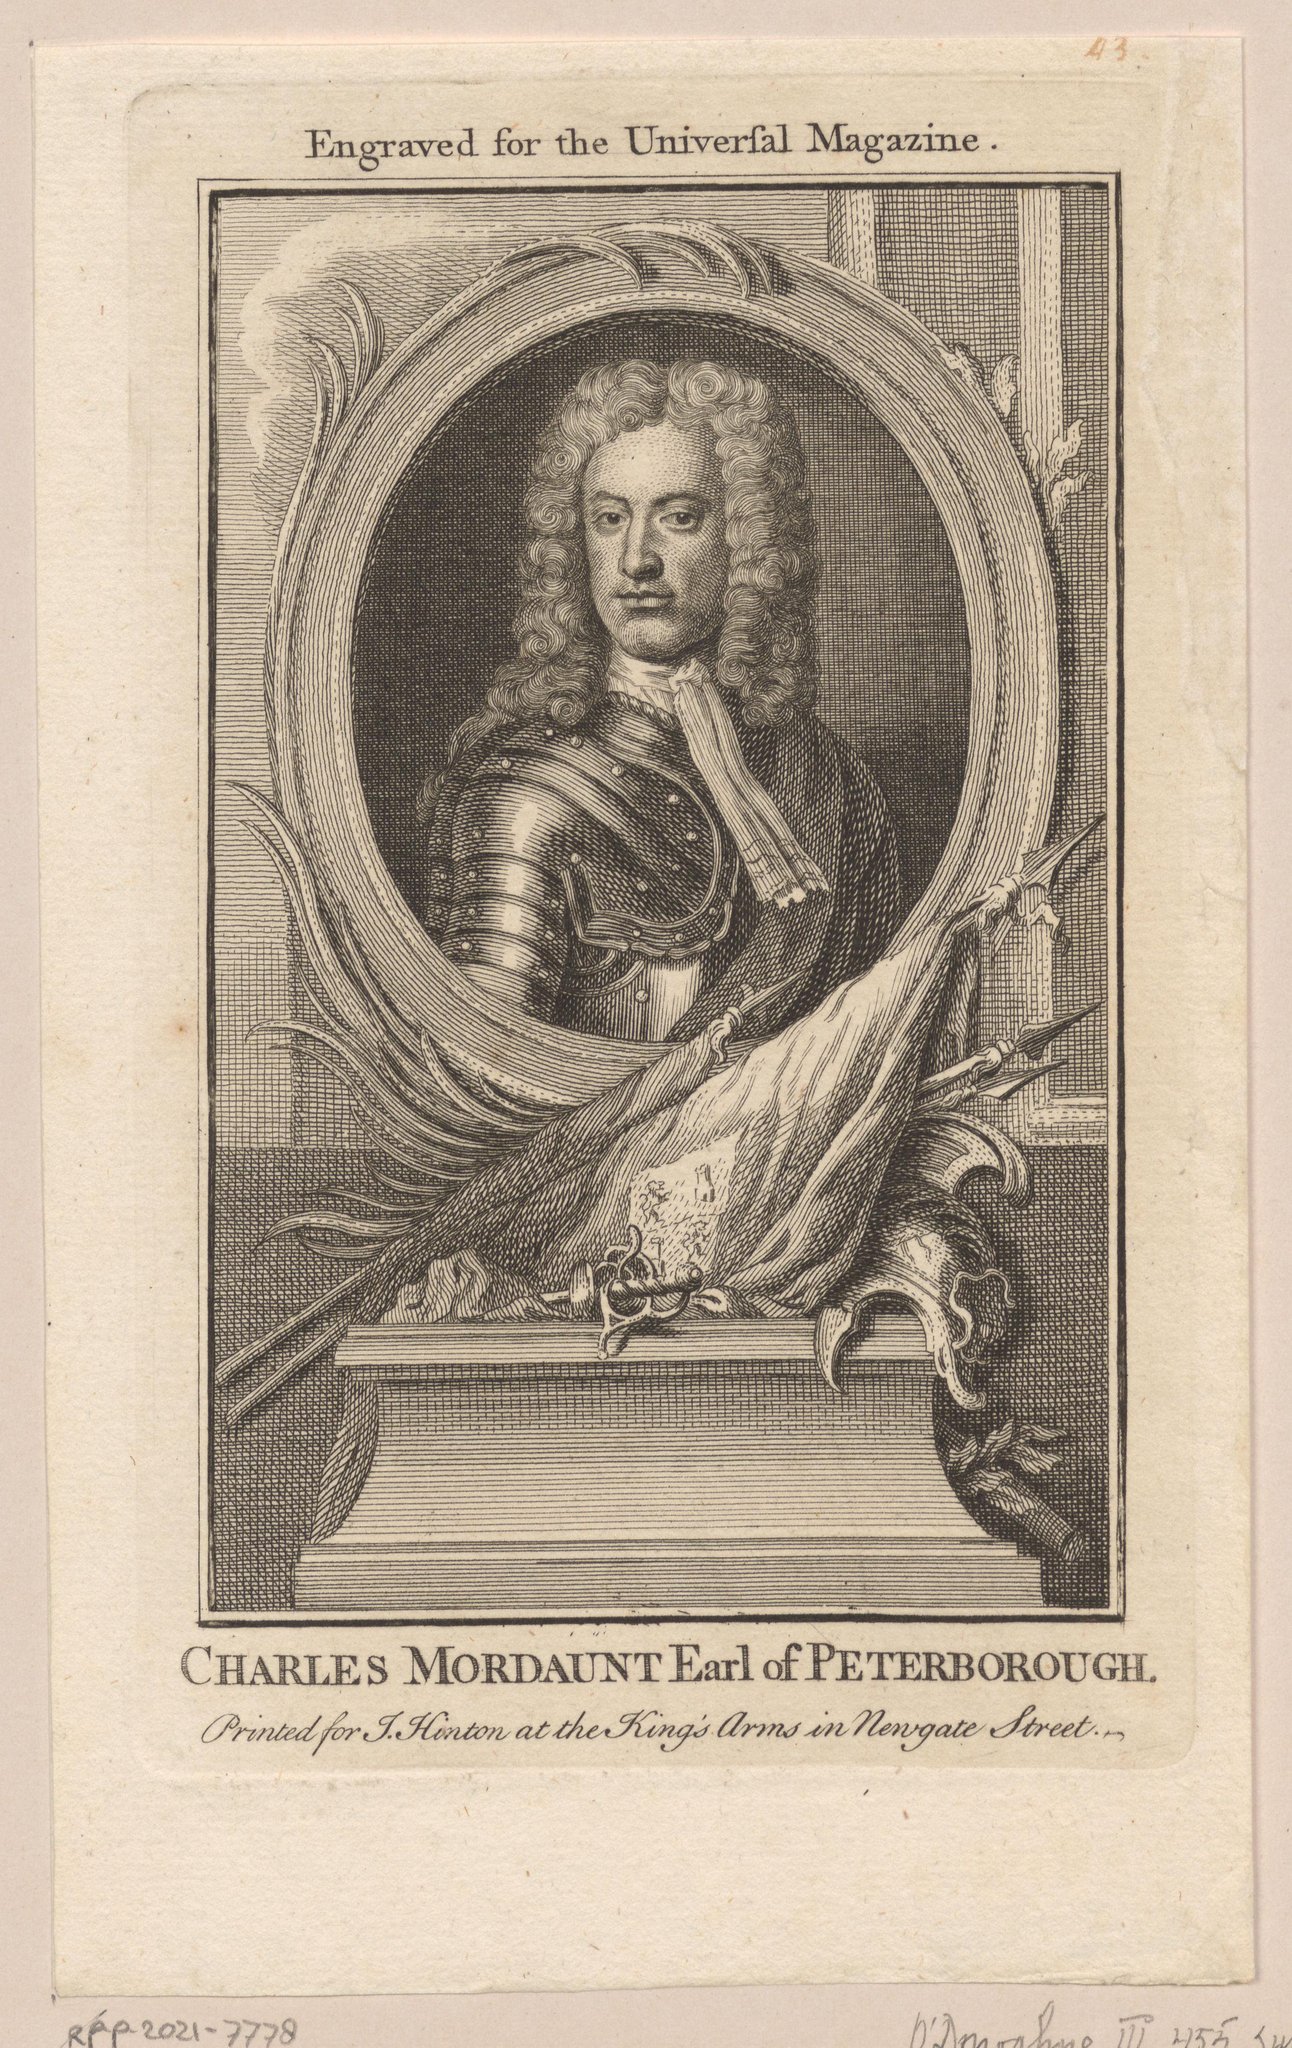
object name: print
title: Portret van Charles Mordaunt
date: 1761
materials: paper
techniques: engraving, etching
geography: london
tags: earl, adult man, historical persons, (military) flags and standards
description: Prent uit: The Universal Magazine of Knowledge and Pleasure 28 (1761).